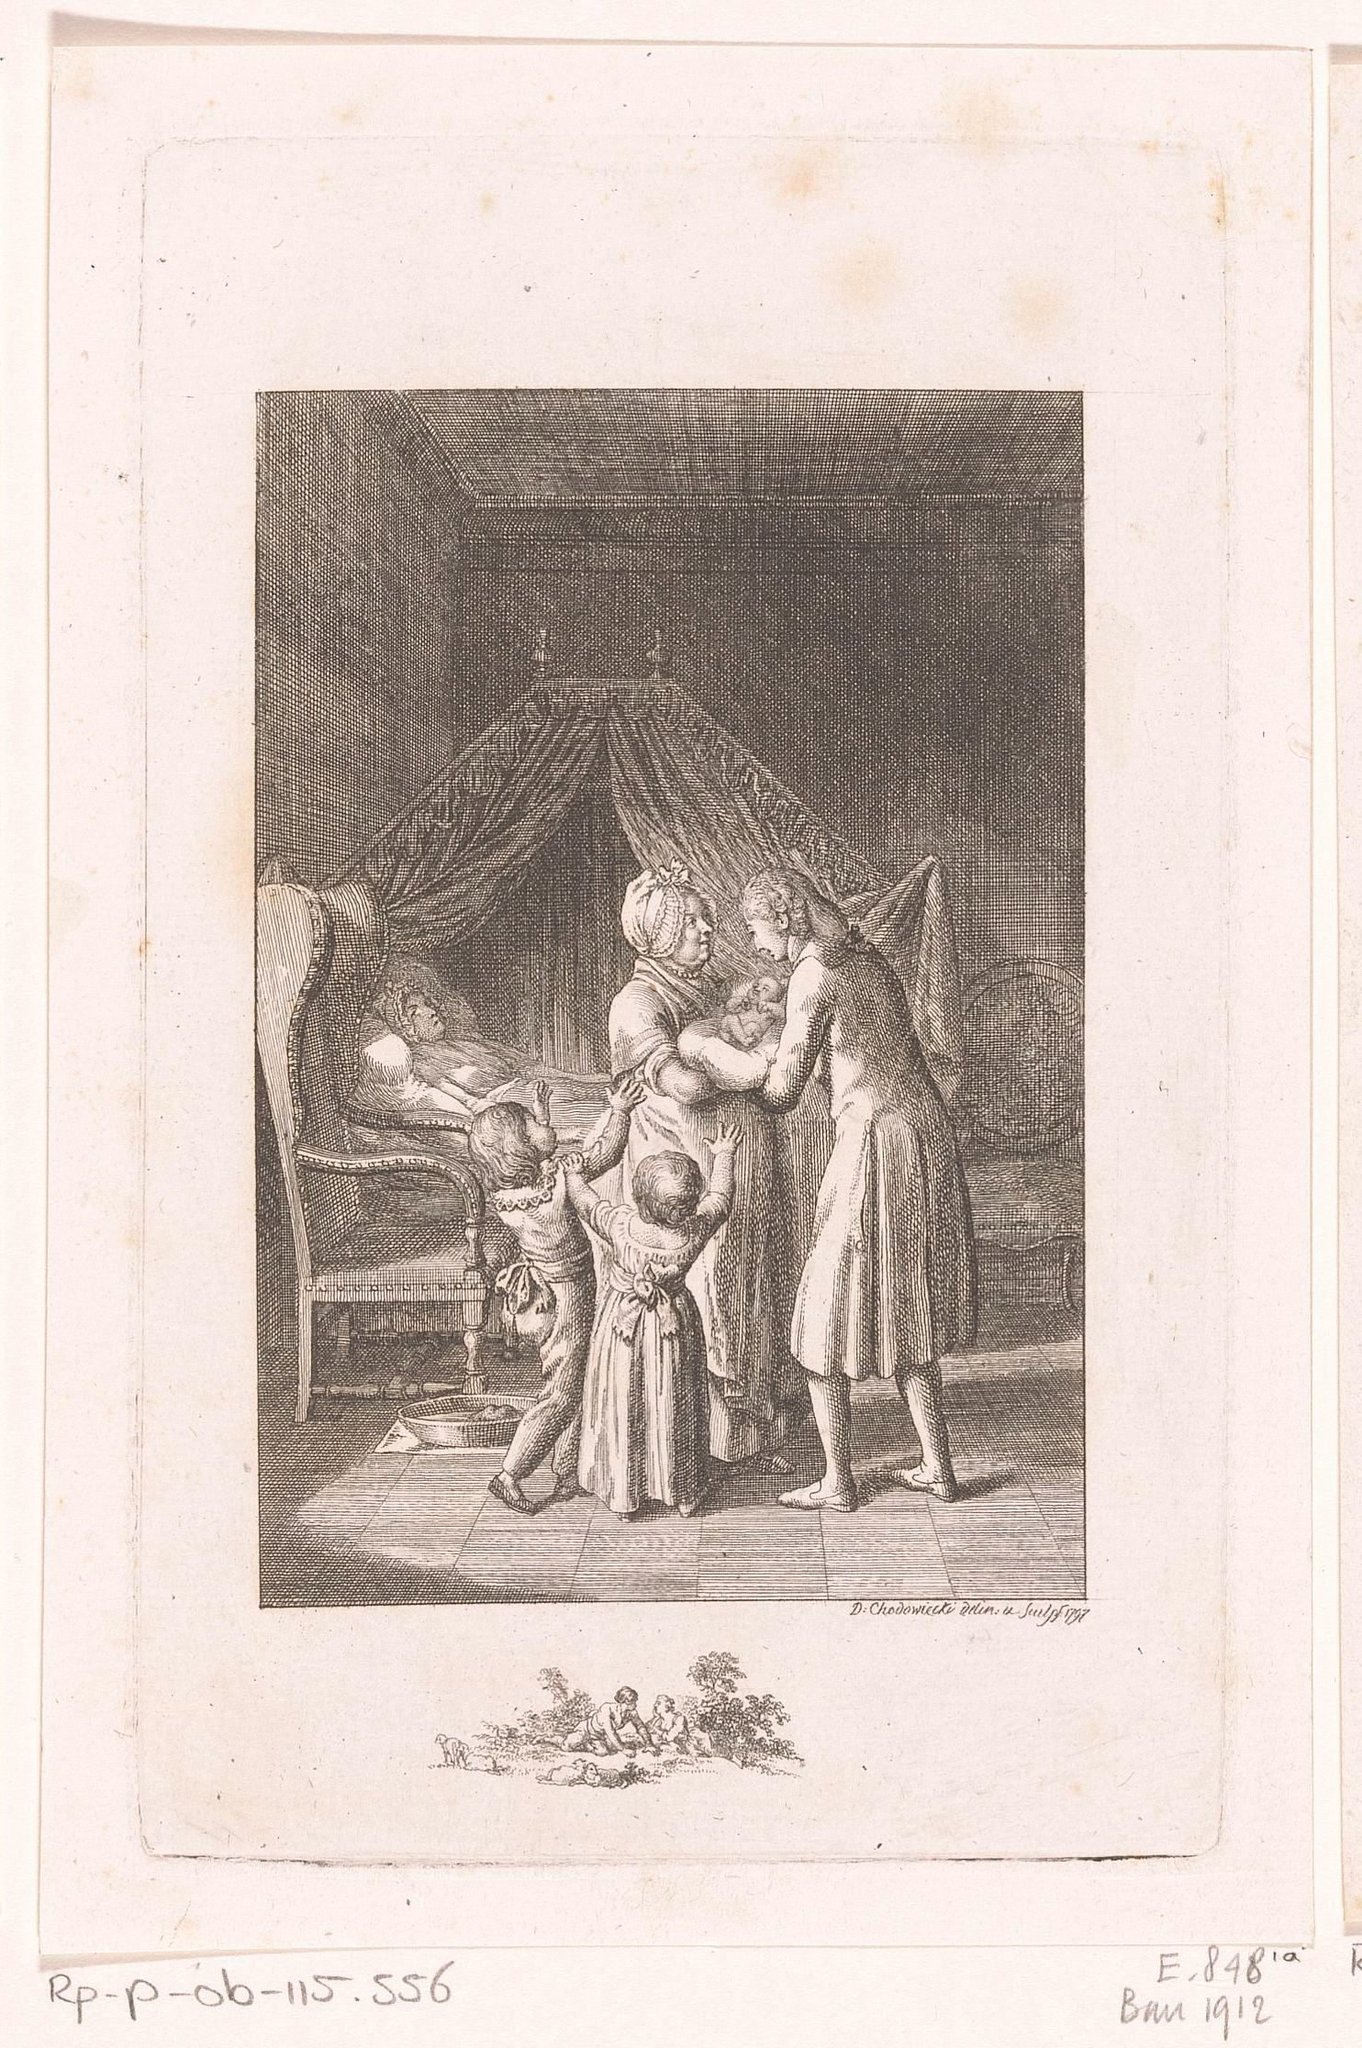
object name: print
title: Vader krijgt zijn nieuwgeboren kind in de armen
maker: daniel nikolaus chodowiecki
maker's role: draughtsman, print maker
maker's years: 1726-1801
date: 1797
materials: paper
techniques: etching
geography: berlin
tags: the new-born child shown to the father, lying-in room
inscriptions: collector's mark: Lugt 2228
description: Latere staat gebruikt voor: Lang, Karl. Almanach und Taschenbuch für Häusliche und Gesellschaftl. Freuden (...). Heilbronn: Industrie Comtoir, s.a.